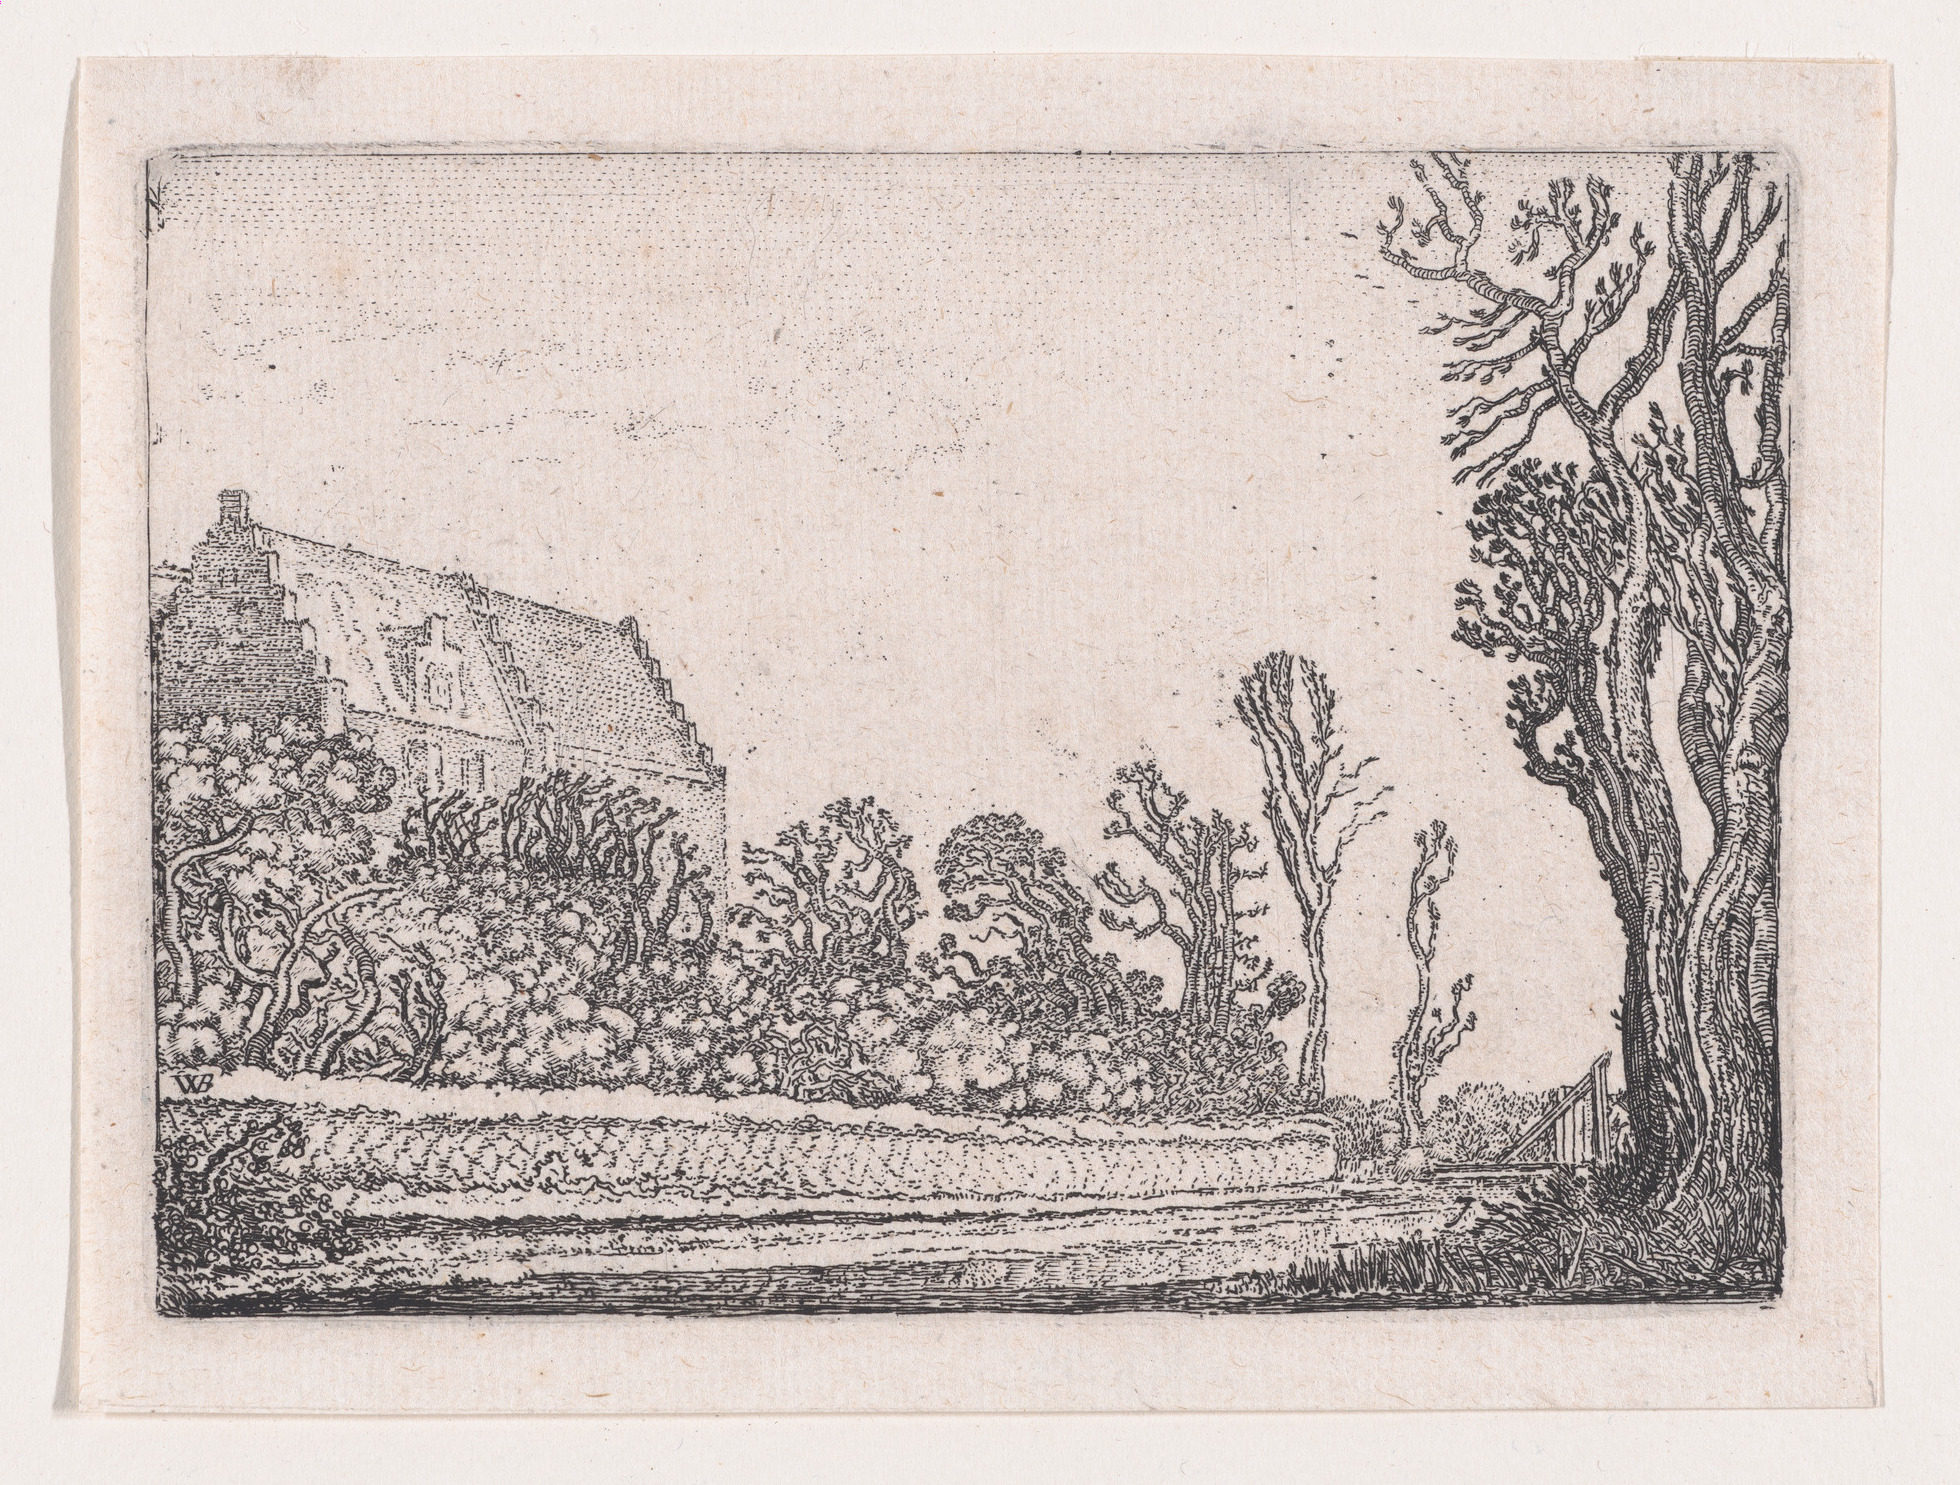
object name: print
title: The House with the Stepped Gable, from Verscheyden Landtschapjes (Various Little Landscapes), Plate 7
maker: willem pietersz buytewech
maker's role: artist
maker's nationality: dutch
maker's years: 1591-1624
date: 1616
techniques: etching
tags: houses,plants